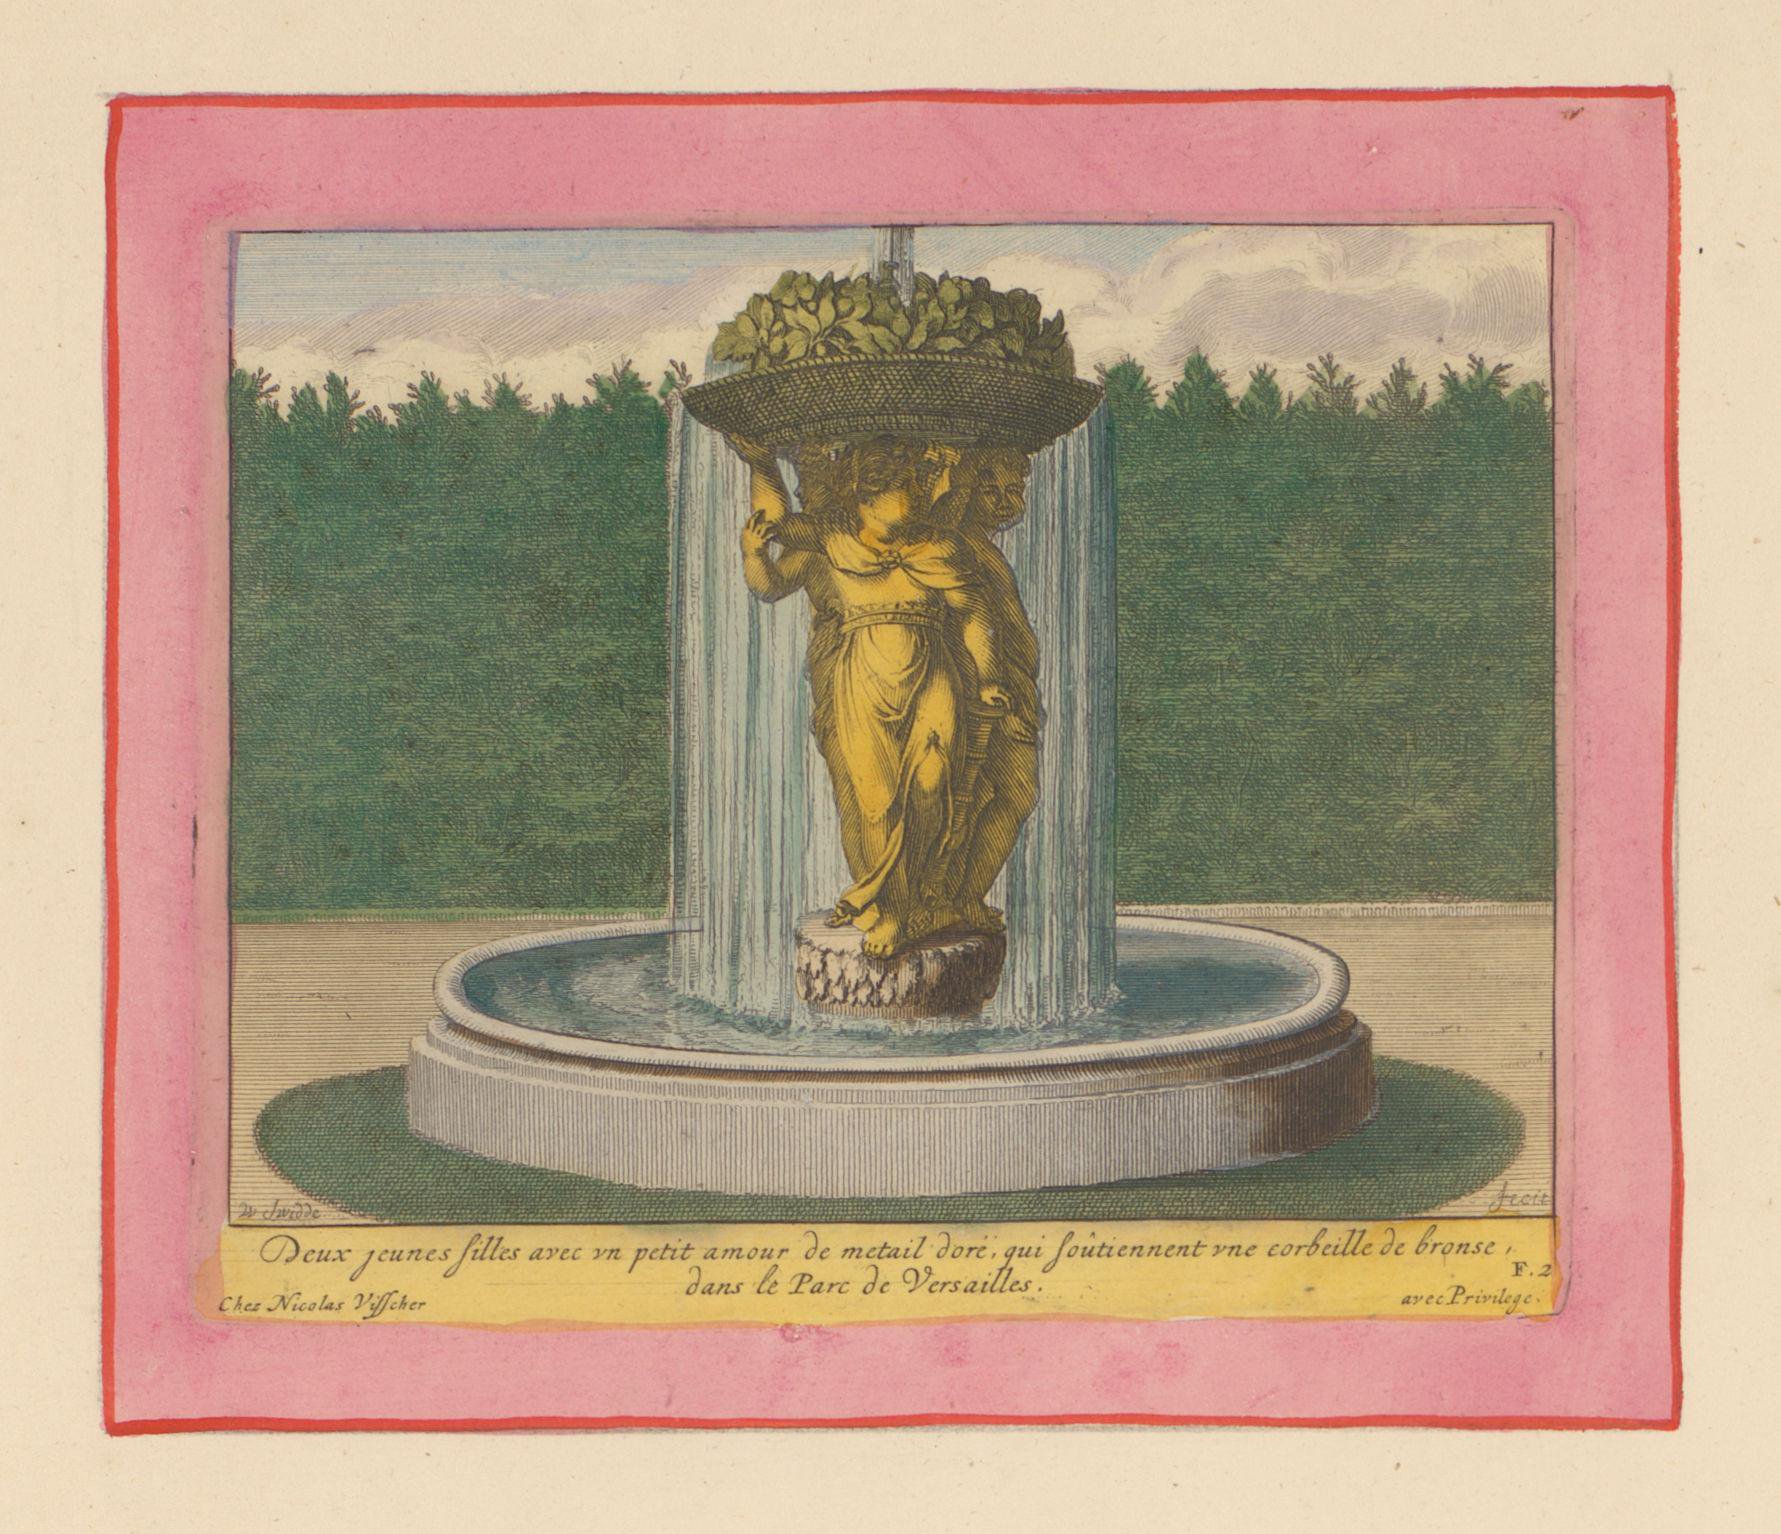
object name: album leaf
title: Deux jeunes filles avec un petit amour de metail doré, qui soûtiennent une corbeille de bronse, dans le Parc de Versailles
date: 1686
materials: paper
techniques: etching, hand coloring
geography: amsterdam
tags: garden fountain, statues, sculptures in garden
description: Fontein met een beeld van drie vrouwen van goudmetaal die een bronzen mand boven hun hoofden dragen in de tuinen van Versailles. Rechtsonder het serienummer: F2. Prent maakt deel uit van een album.